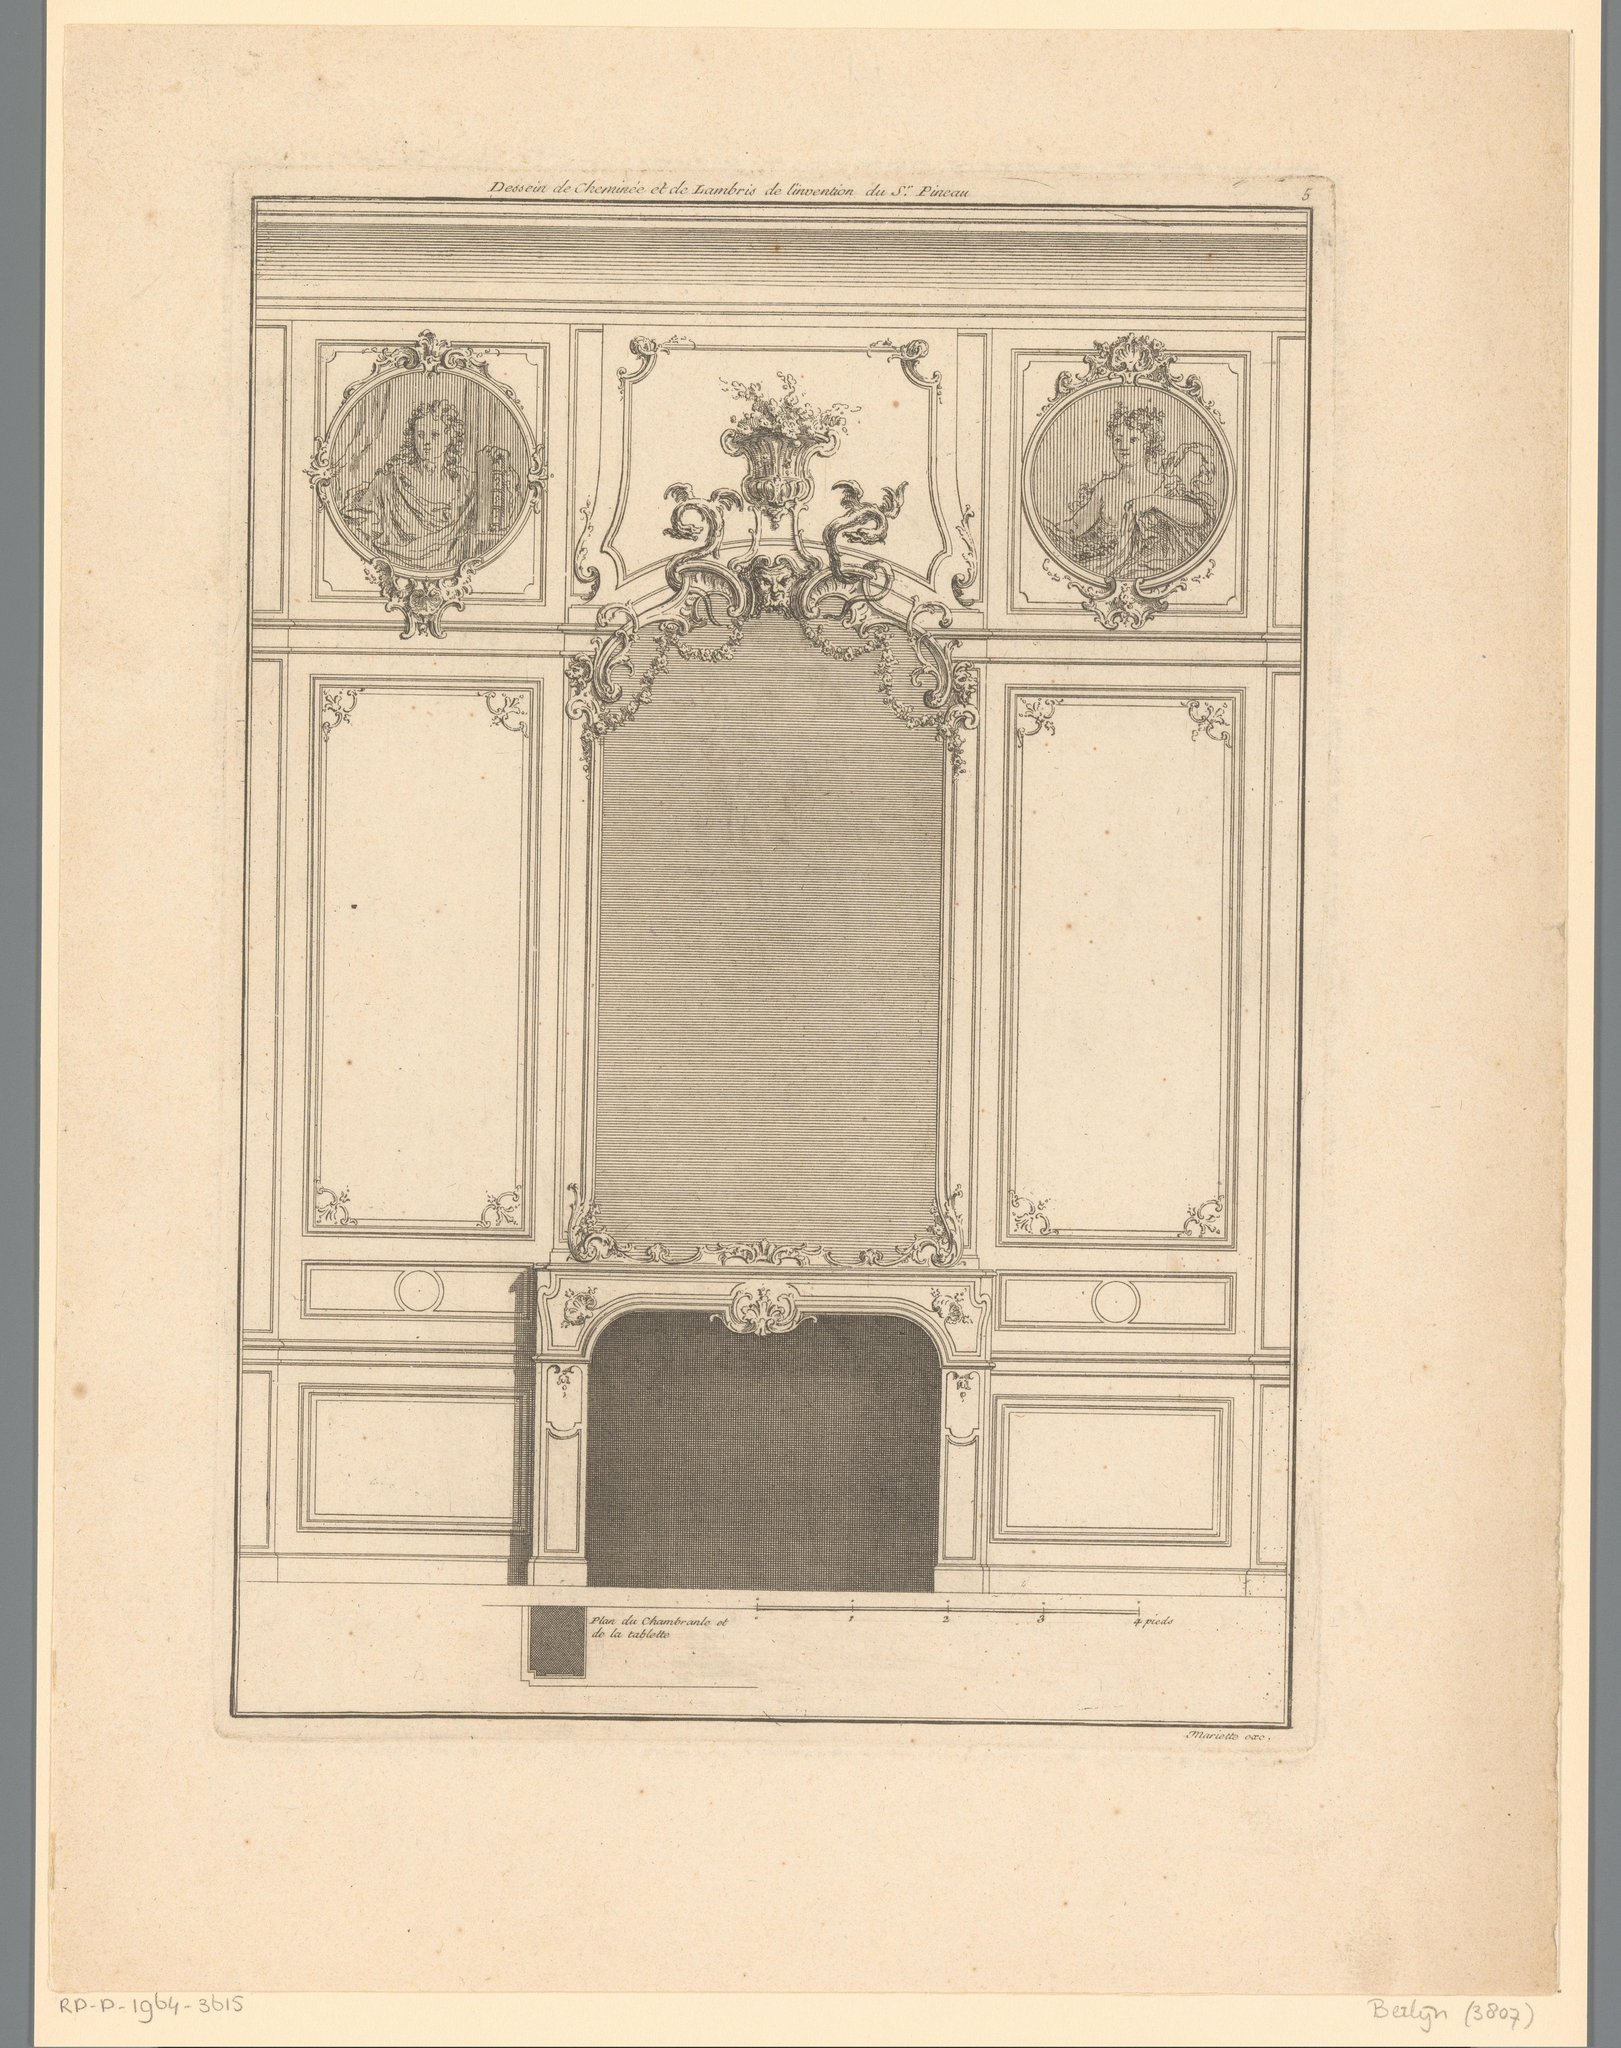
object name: print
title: Schouwen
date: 1694-1742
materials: paper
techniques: engraving, etching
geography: paris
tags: ornament ~ medallion, open hearth, fire-place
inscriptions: collector's mark: Lugt 2228, collector's mark: Lugt 2760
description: Een geornamenteerde schouw met rocaille ornamenten en aan de bovenzijde guirlandes, een vaas en draken. Links- en rechts boven ronde medaillons met een figuur met een boek en een vrouw.